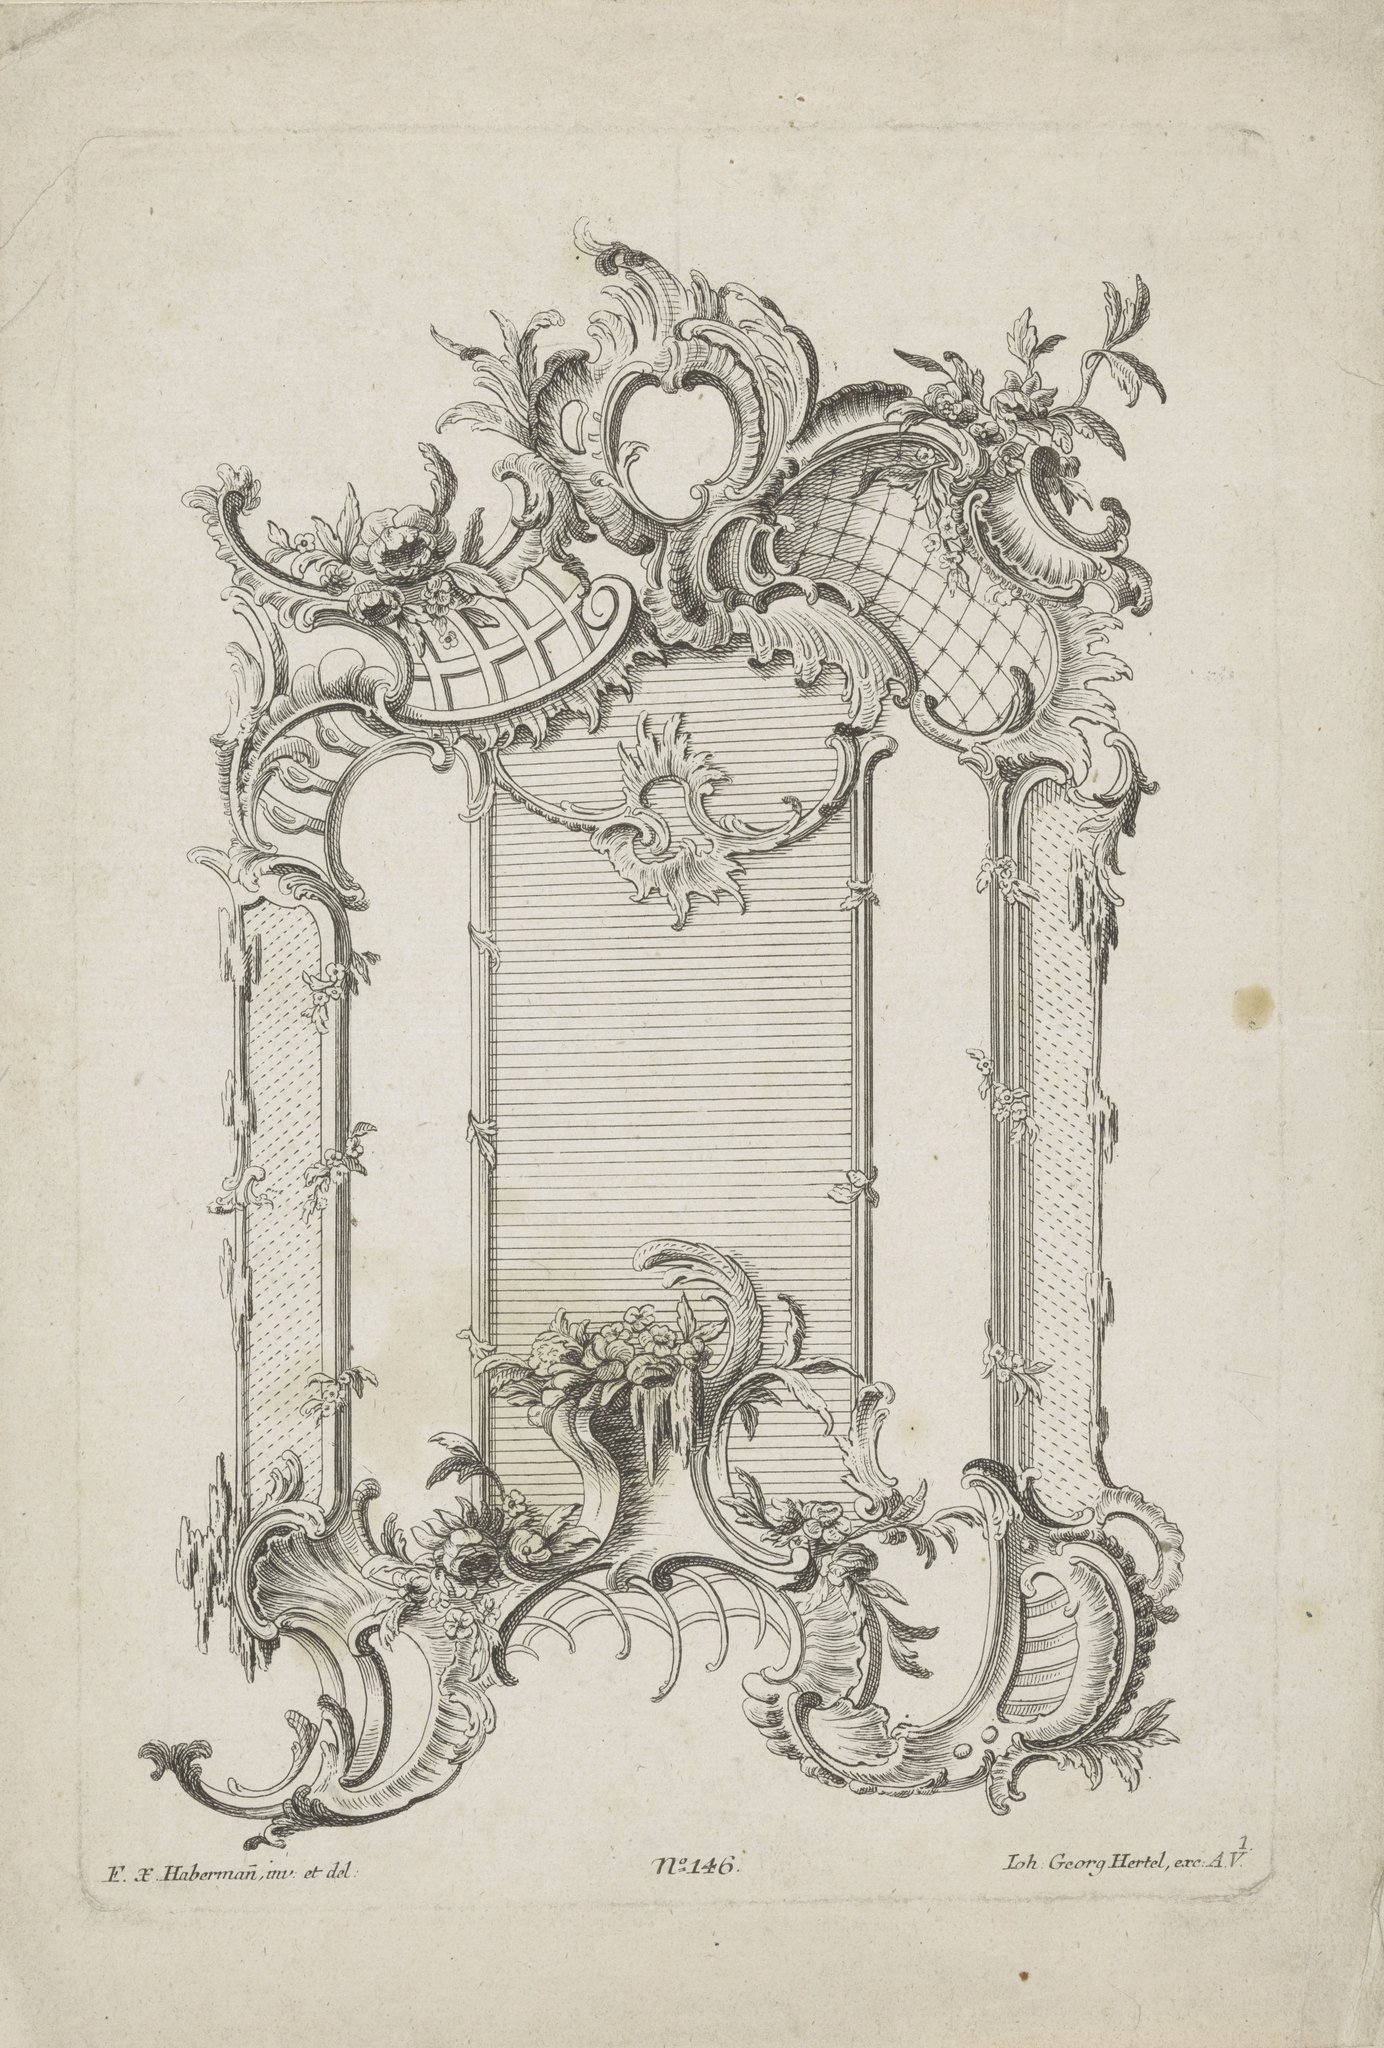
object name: ornament print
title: Rocaille omlijsting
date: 1731-1775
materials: paper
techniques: etching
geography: augsburg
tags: rocaille ornament, ornaments ~ art (+ framing decorations)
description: Omlijsting met rocaille ornamenten en bloemmotieven. Uitgeversnummer 146.